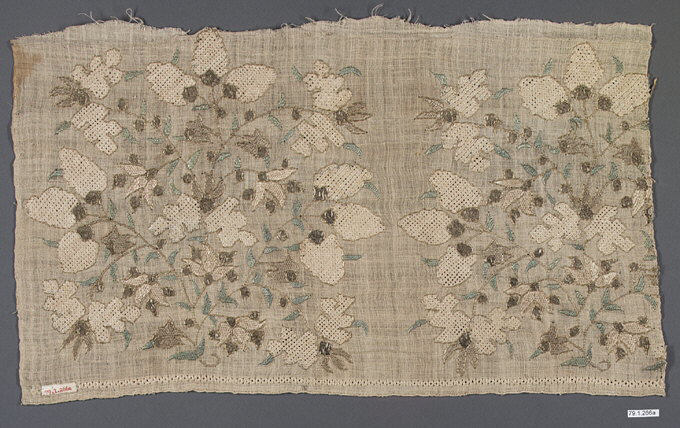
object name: towel end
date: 1801-1833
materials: linen, metal thread, silk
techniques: embroidery, weave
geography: turkey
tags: flowers